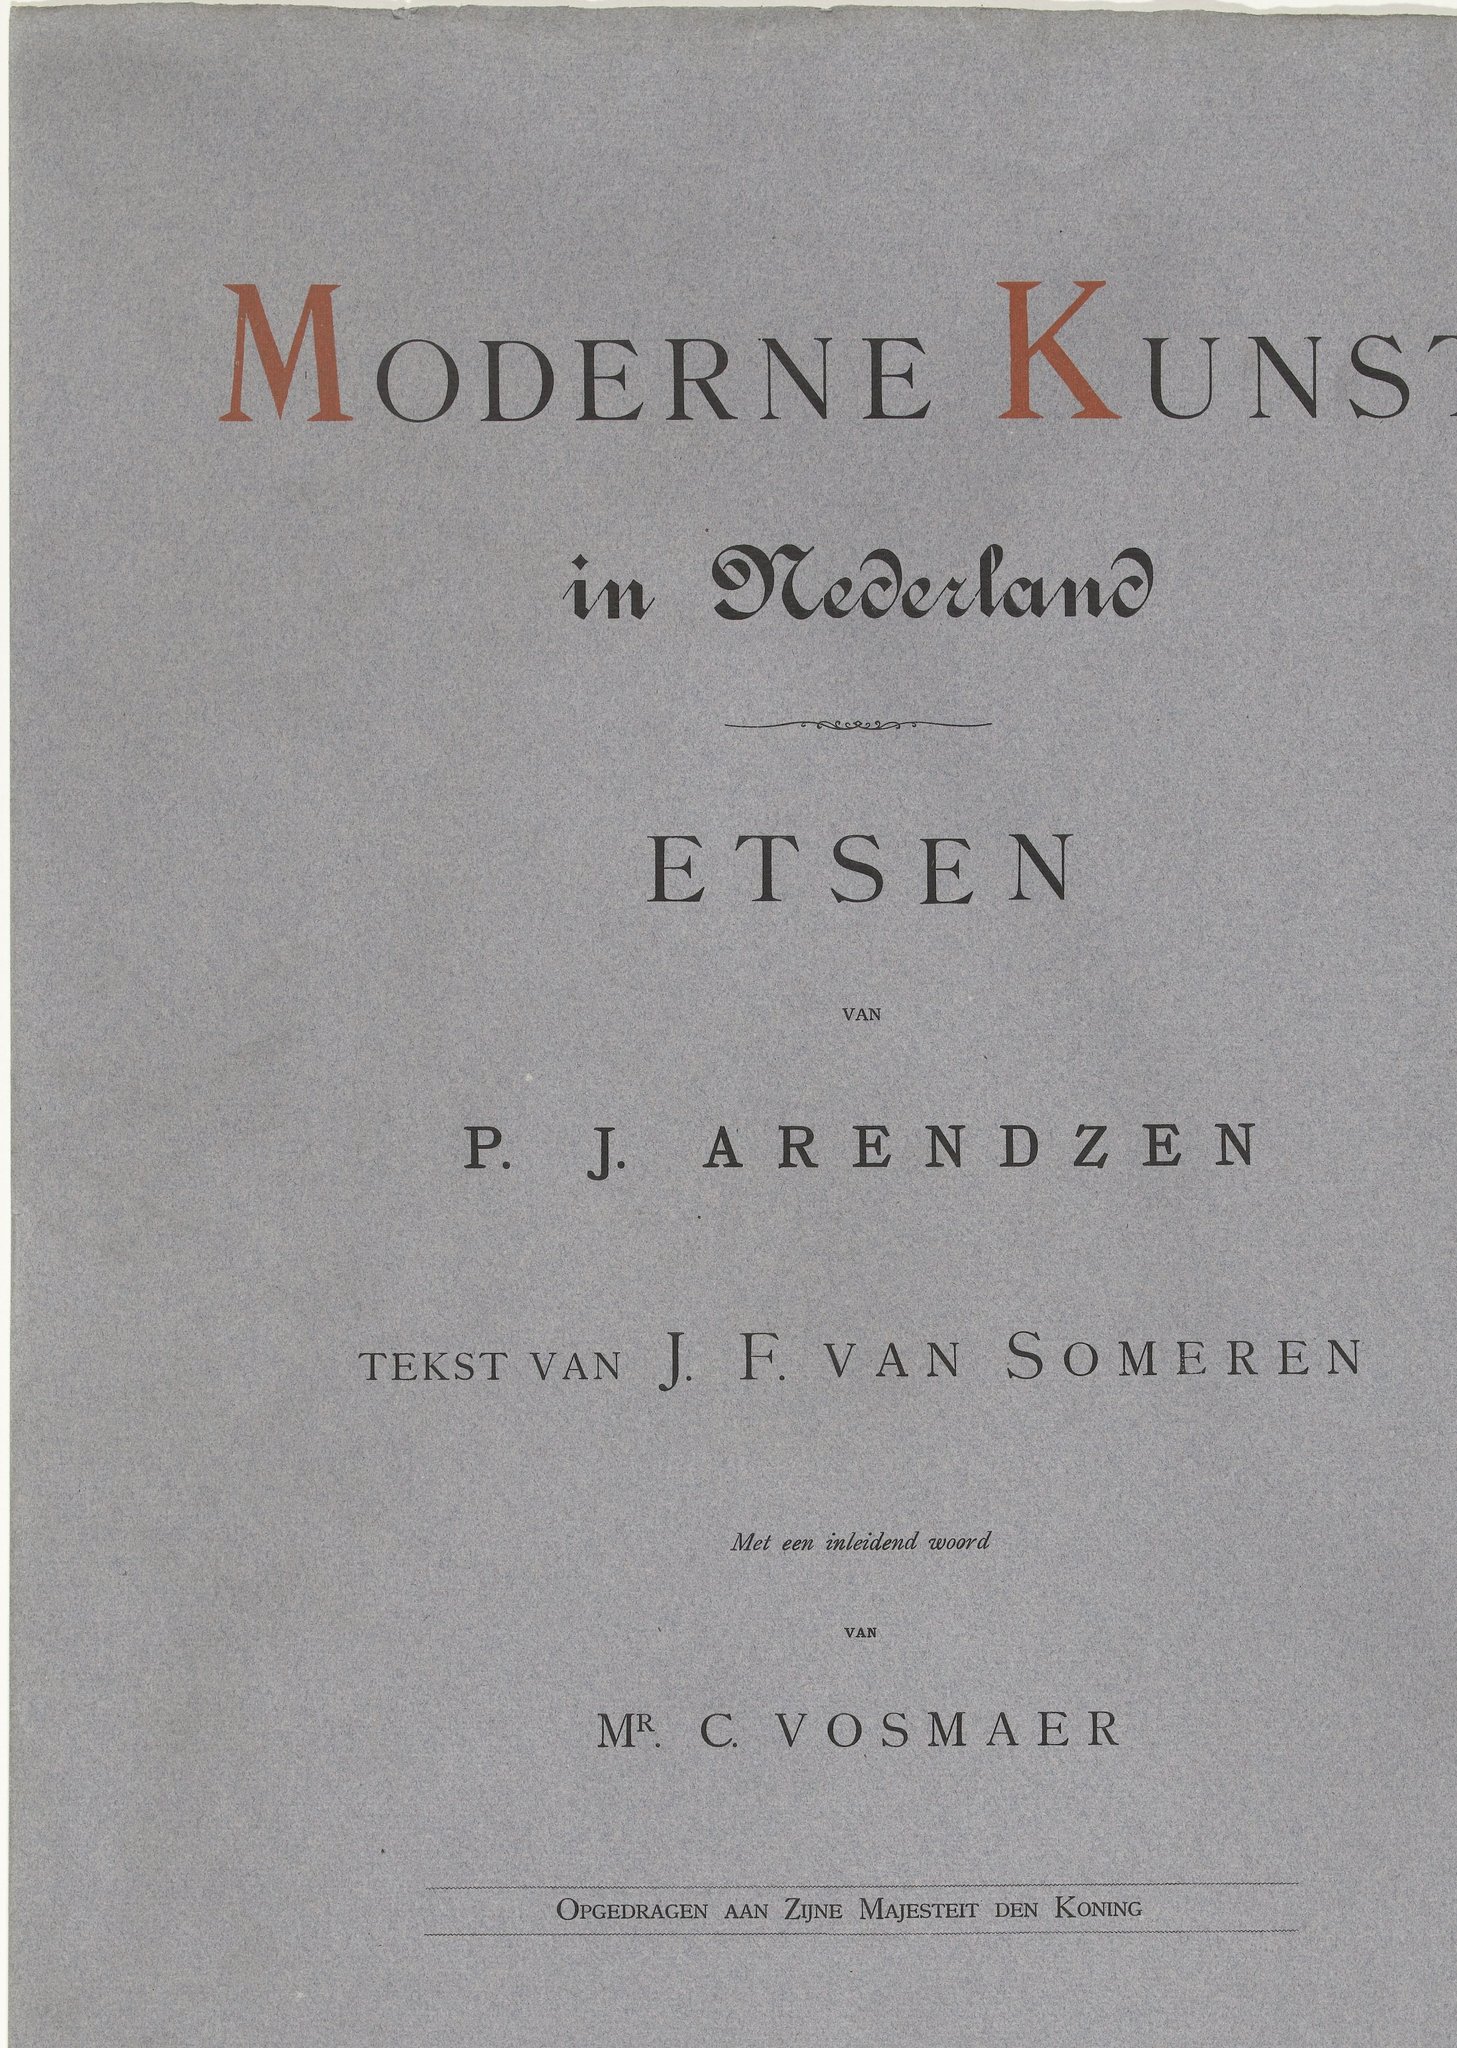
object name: wrapper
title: Omslag voor "Moderne Kunst in Nederland. Etsen van P.J. Arendzen, tekst van J.F. Someren", aflevering 25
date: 1883-1887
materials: paper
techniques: letterpress printing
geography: amsterdam